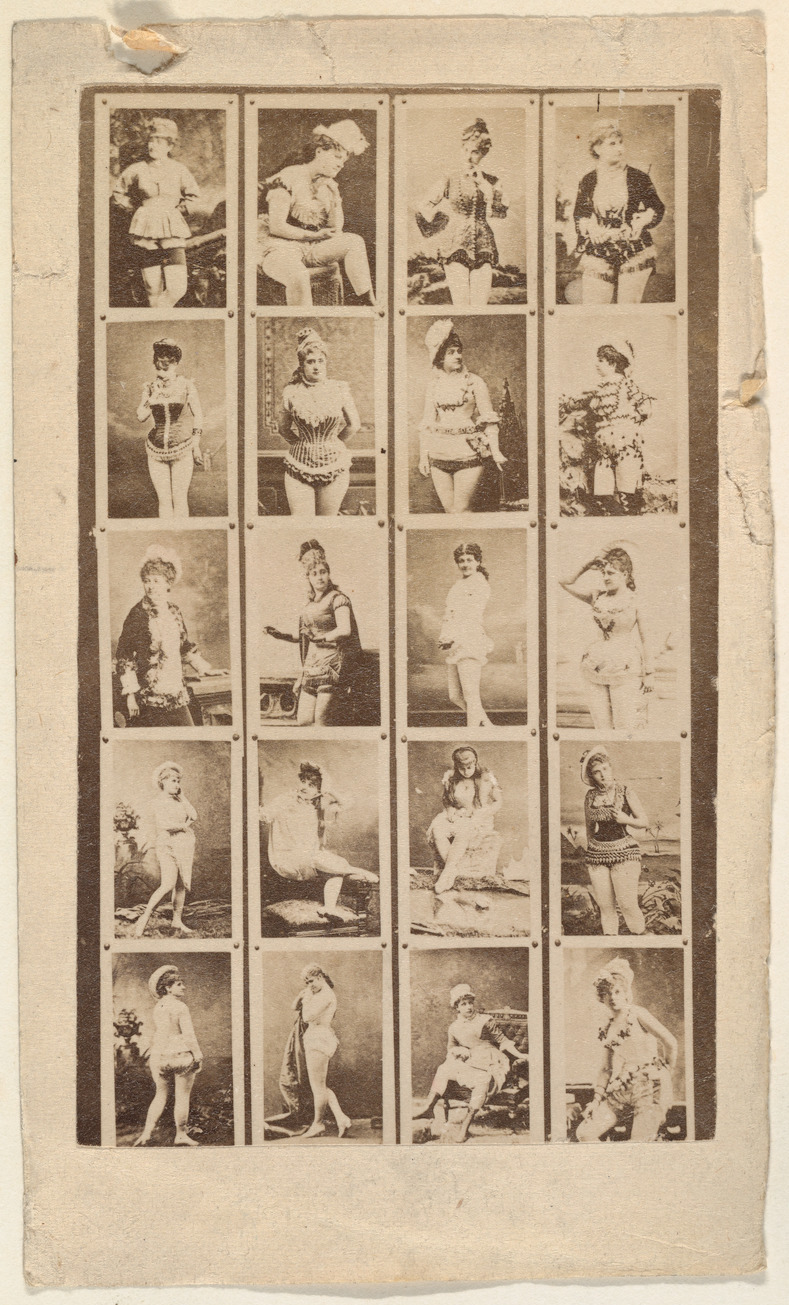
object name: photograph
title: Grid of twenty portraits of actresses, from the Actresses series (N668)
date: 1888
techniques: albumen silver print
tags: portraits,women,actresses